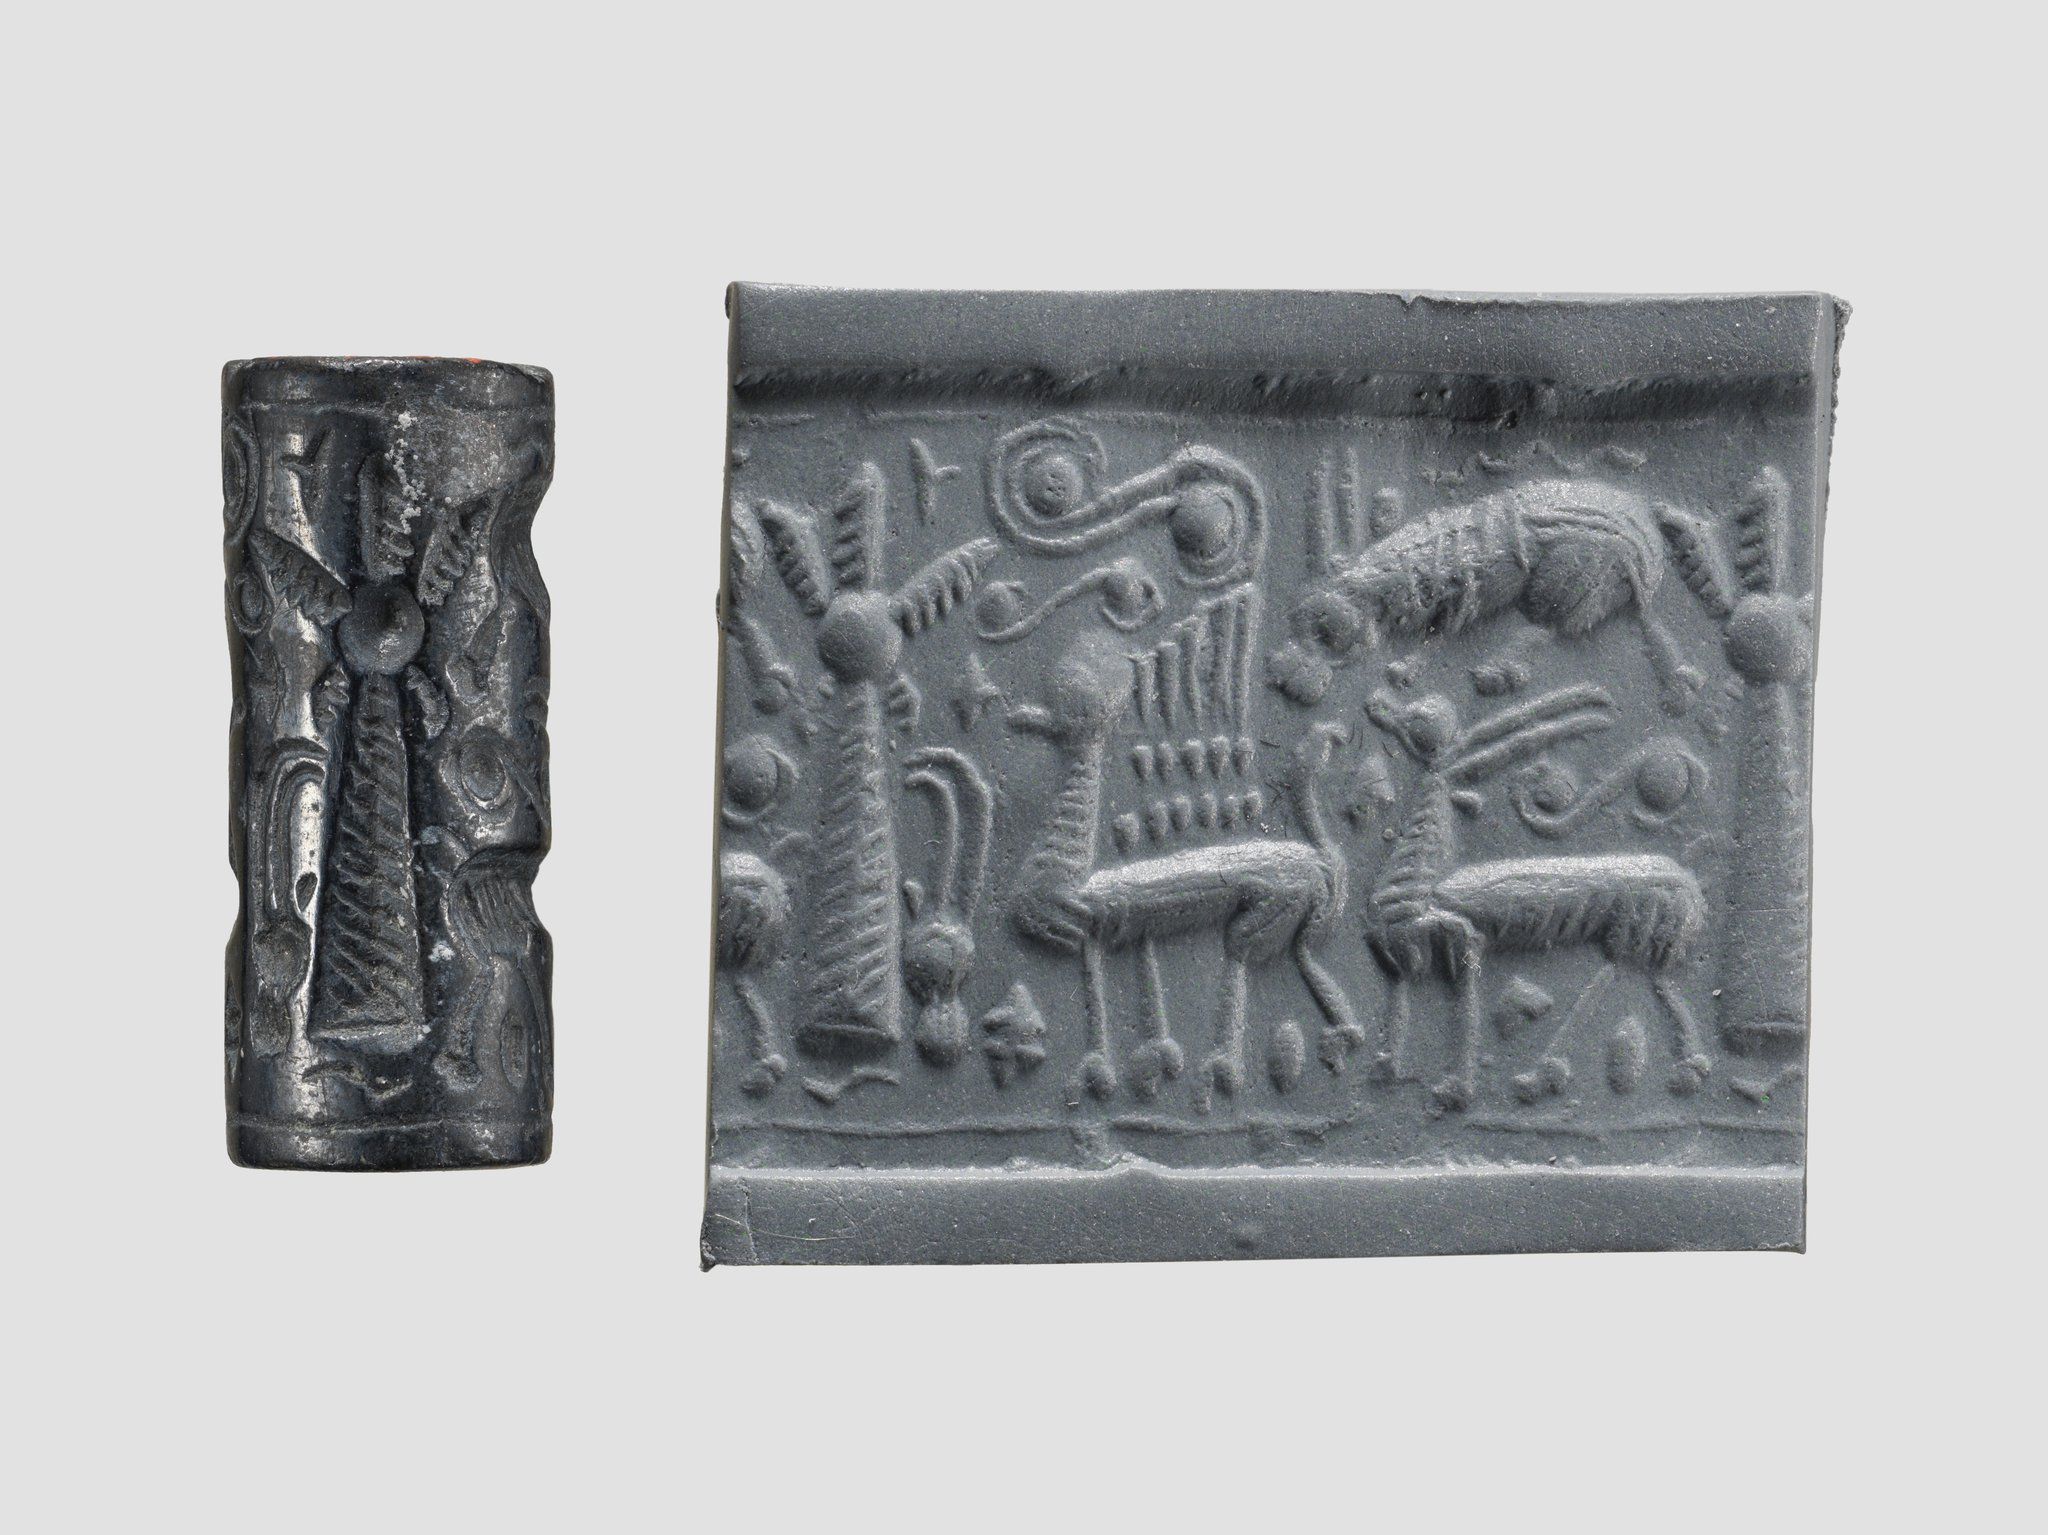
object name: cylinder seal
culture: cypriot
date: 1400-1101 BCE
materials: mineral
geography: cyprus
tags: sphinx,trees,antelope